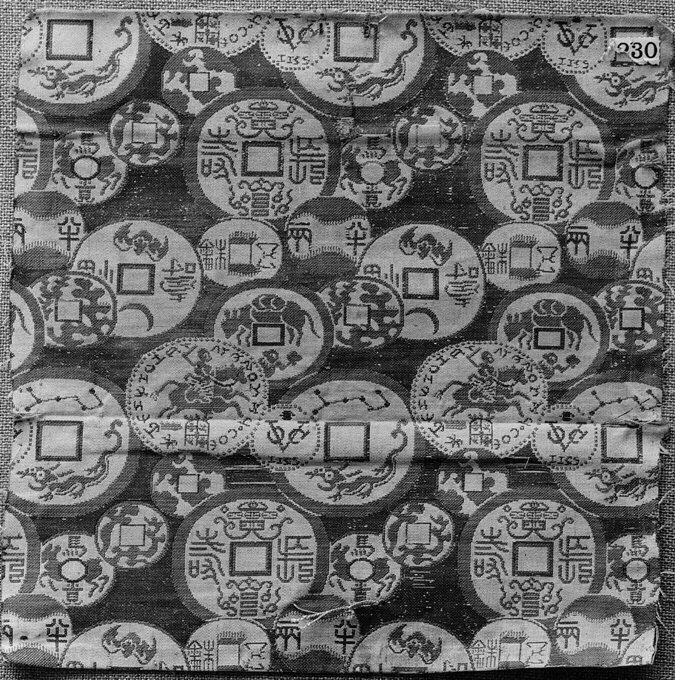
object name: piece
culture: japanese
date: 1801-1900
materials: metal thread, silk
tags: human figures,animals